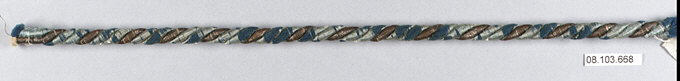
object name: cord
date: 1801-1900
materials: metal thread, silk